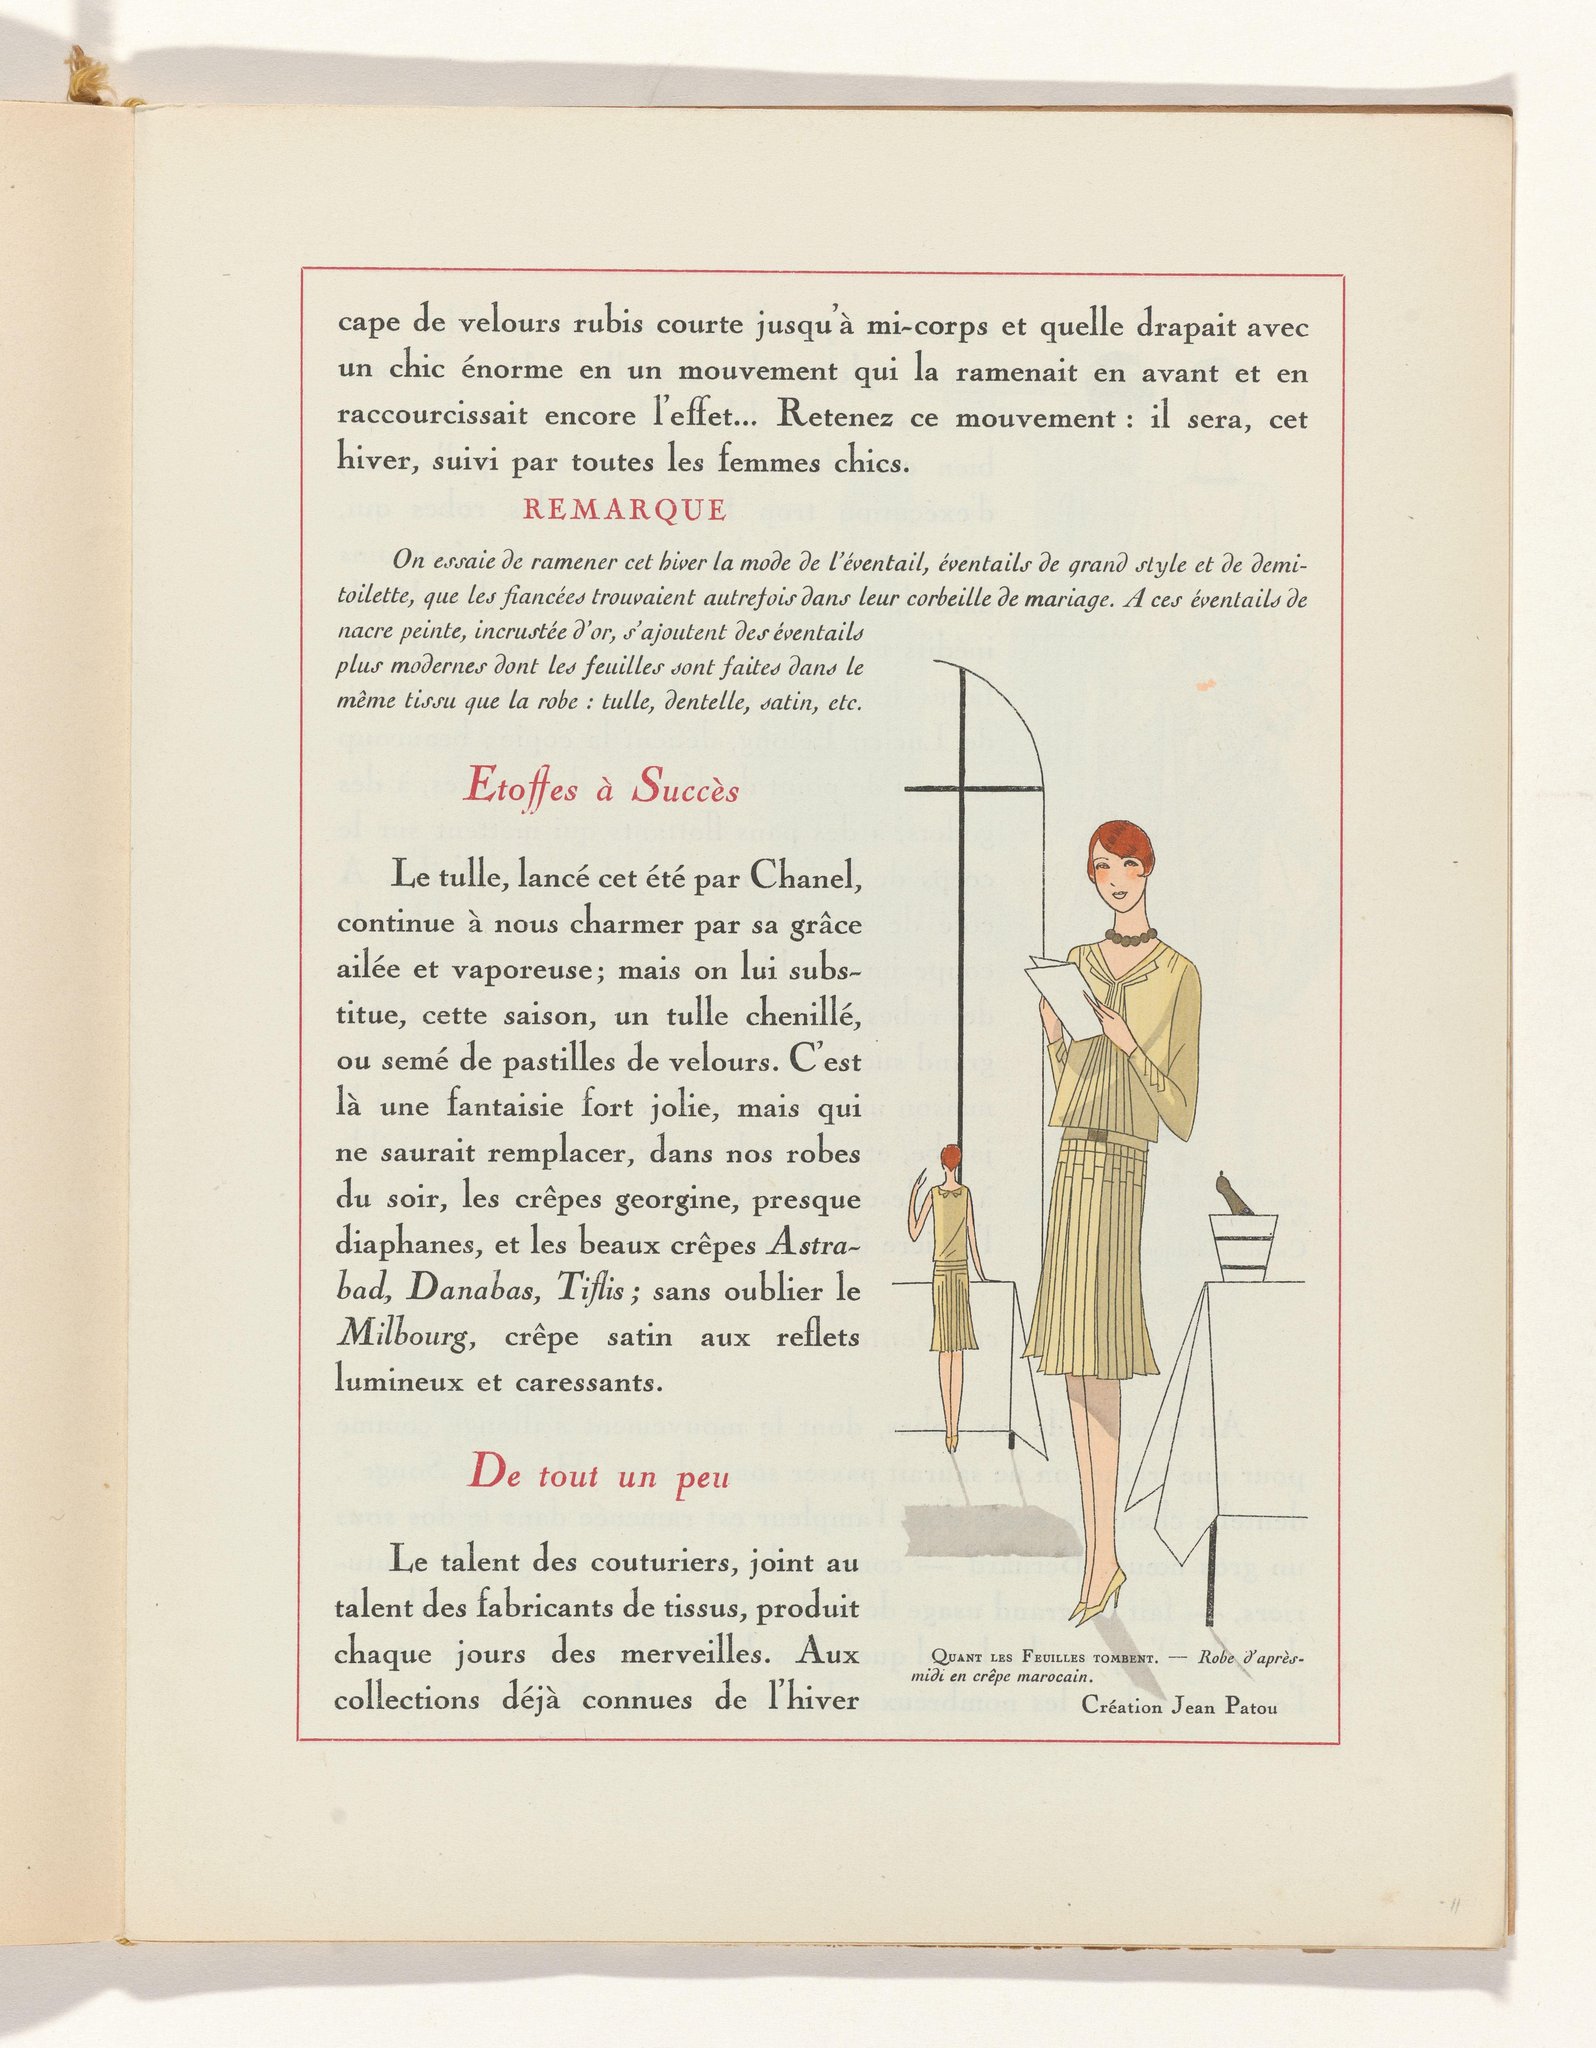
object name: fashion print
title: Art - Goût - Beauté, Feuillets de l' élégance féminine, Novembre 1928, No. 99, 9e Année, p. 11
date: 1928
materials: paint, paper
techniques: brush, hand coloring, lithograph, pochoir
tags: dress, gown: day dress (+ women's clothes), fashion plates, necklace (+ women's clothes)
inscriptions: caption: ‘QUANT LES FEUILLES TOMBENT. - Robe d'après-midi en crêpe marocain. / Création Jean Patou’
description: Tekst met een afbeelding van een vrouw gekleed in een middagjapon van 'crêpe marocain', van Jean Patou. Pagina uit het modetijdschrift Art-Goût-Beauté (1920-1933).